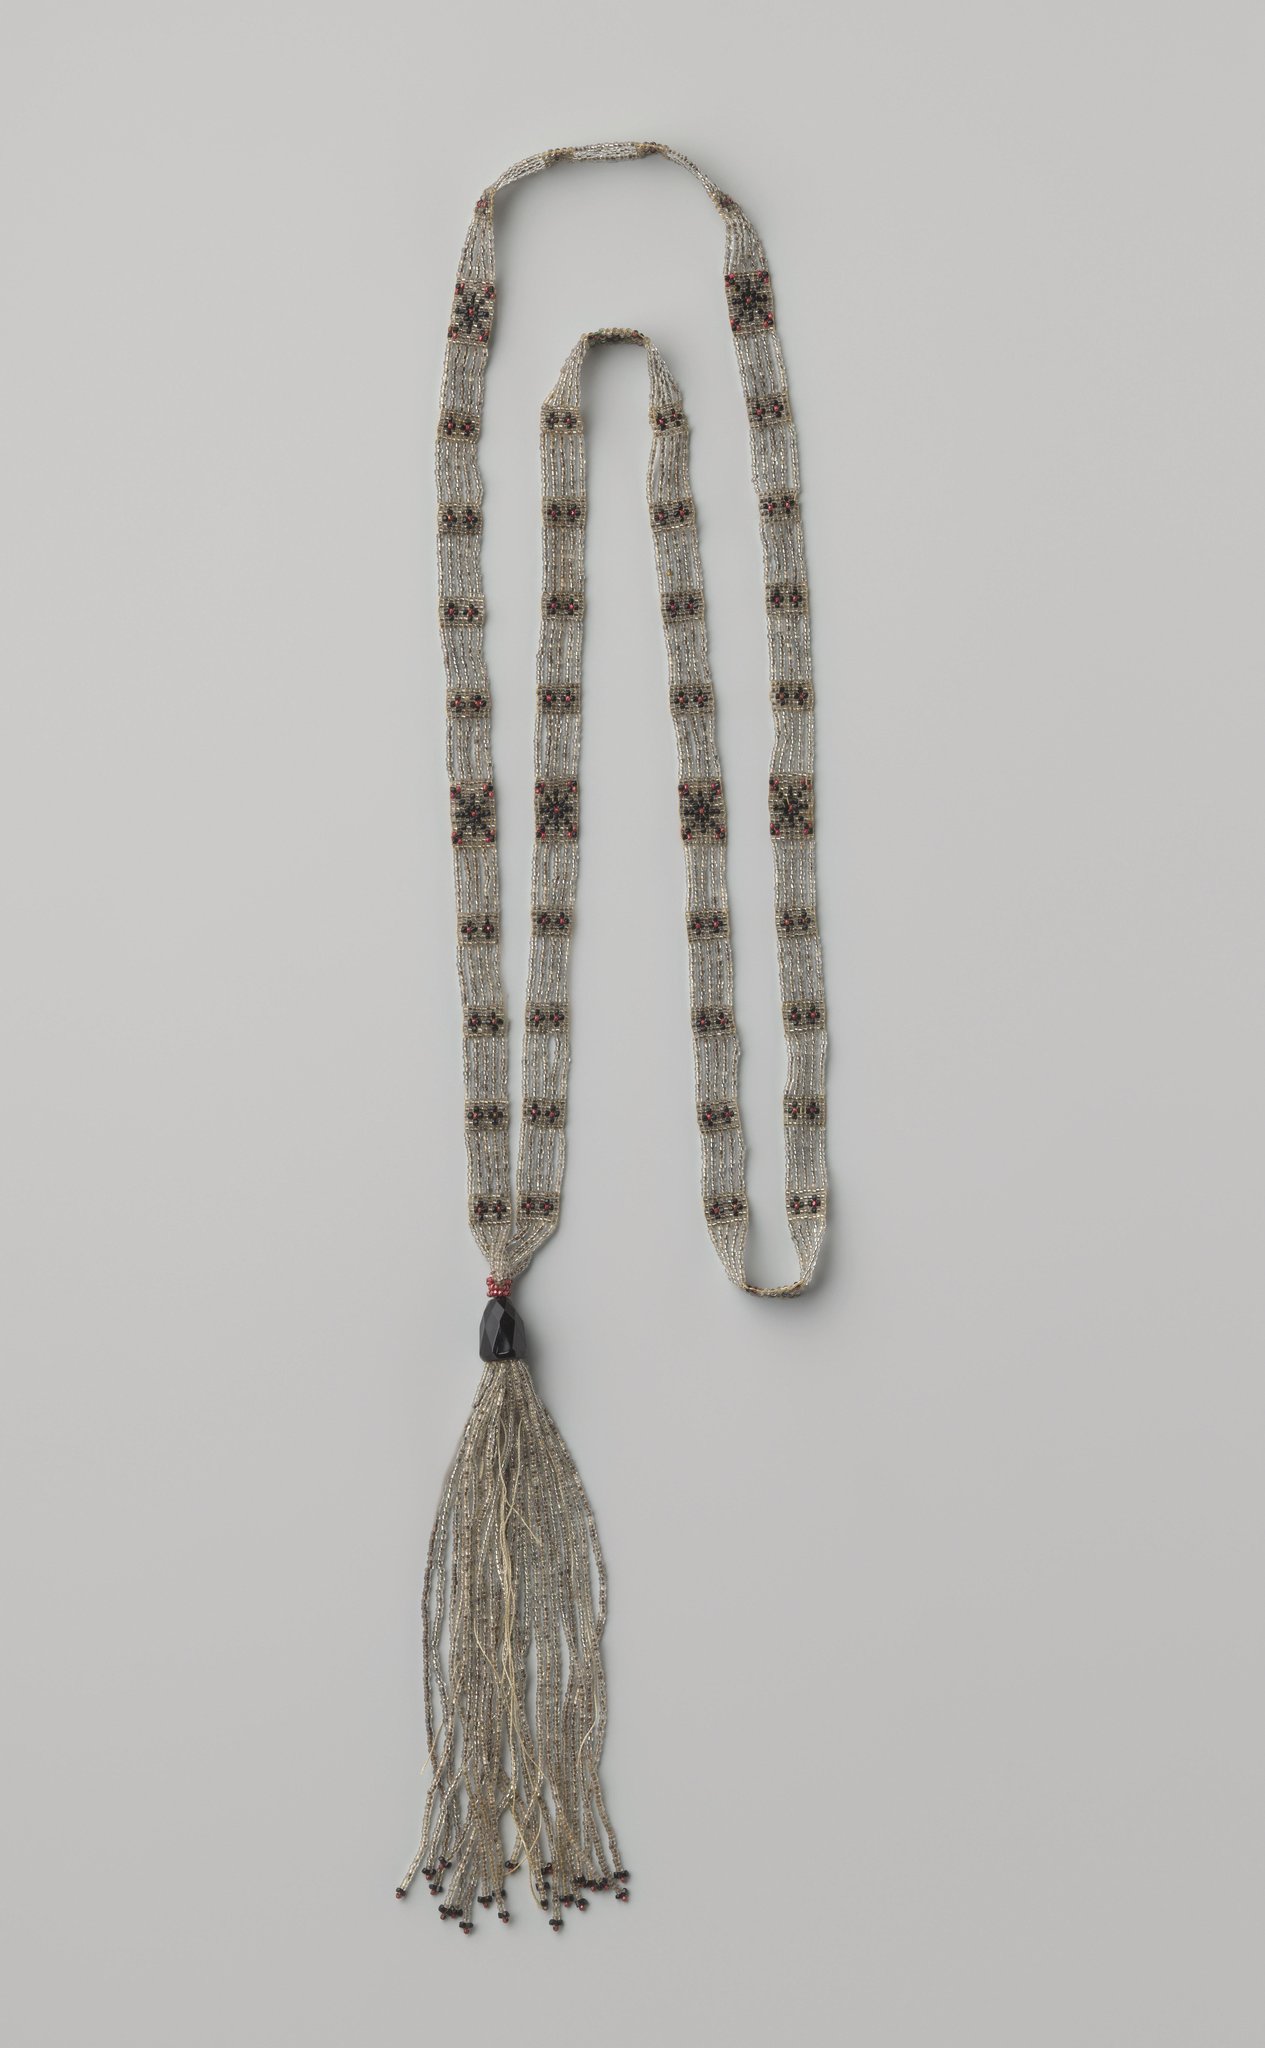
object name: necklace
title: Charlestoncollier van draad en kralen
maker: Anonymous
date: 1920-1930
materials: thread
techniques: sewing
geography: netherlands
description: Charlestoncollier van zilverdraad en wijnrode, transparante en zwarte kralen.